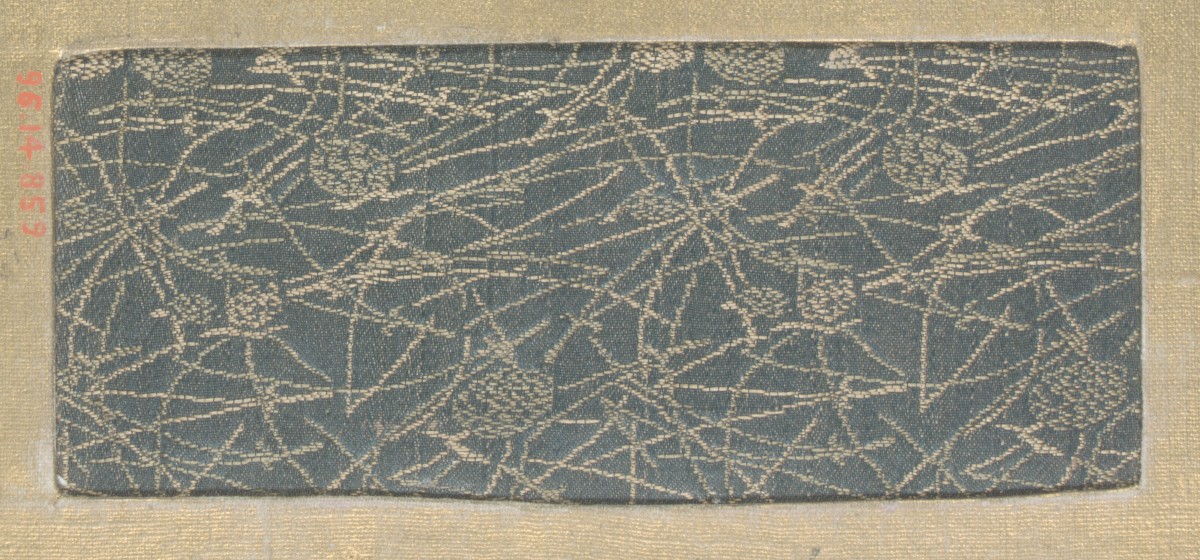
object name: piece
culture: japanese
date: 1701-1900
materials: silk